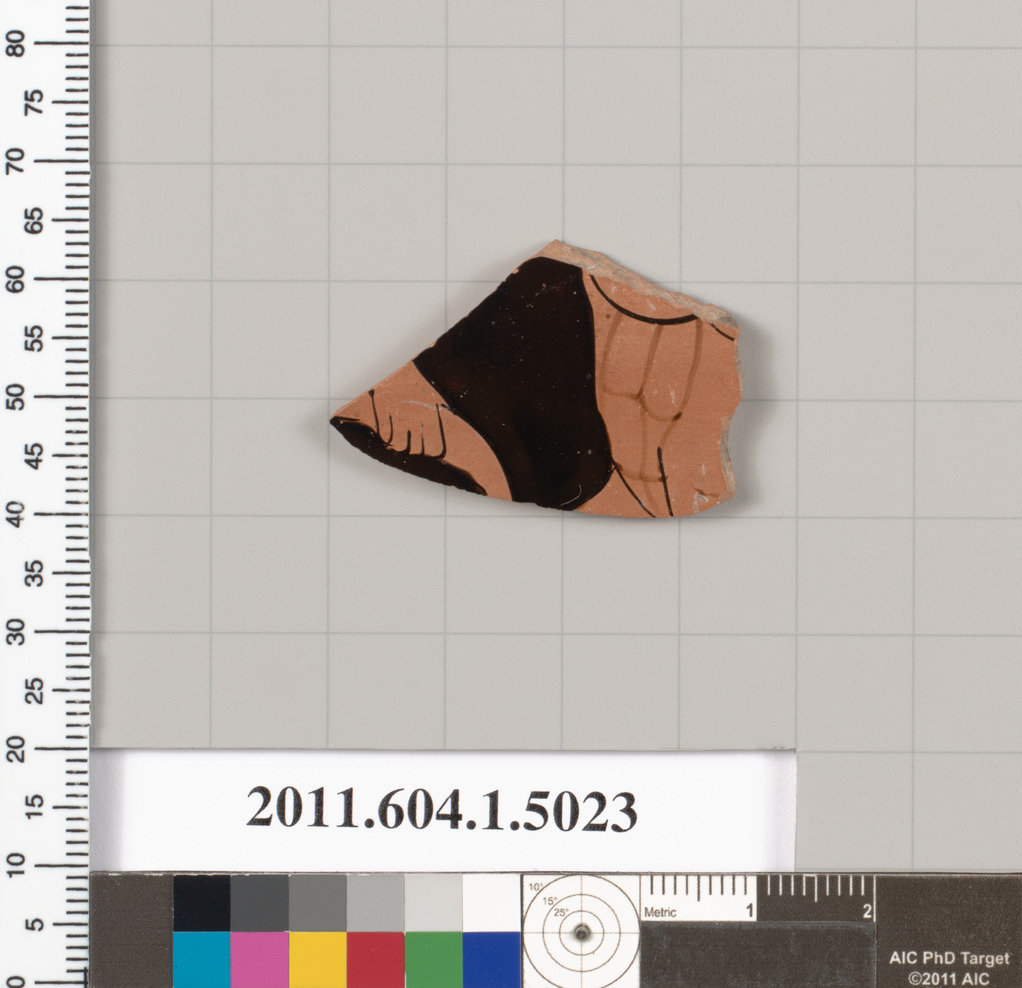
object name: kylix fragment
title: Terracotta fragment of a kylix (drinking cup)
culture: greek, attic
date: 500-480 BCE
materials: terracotta